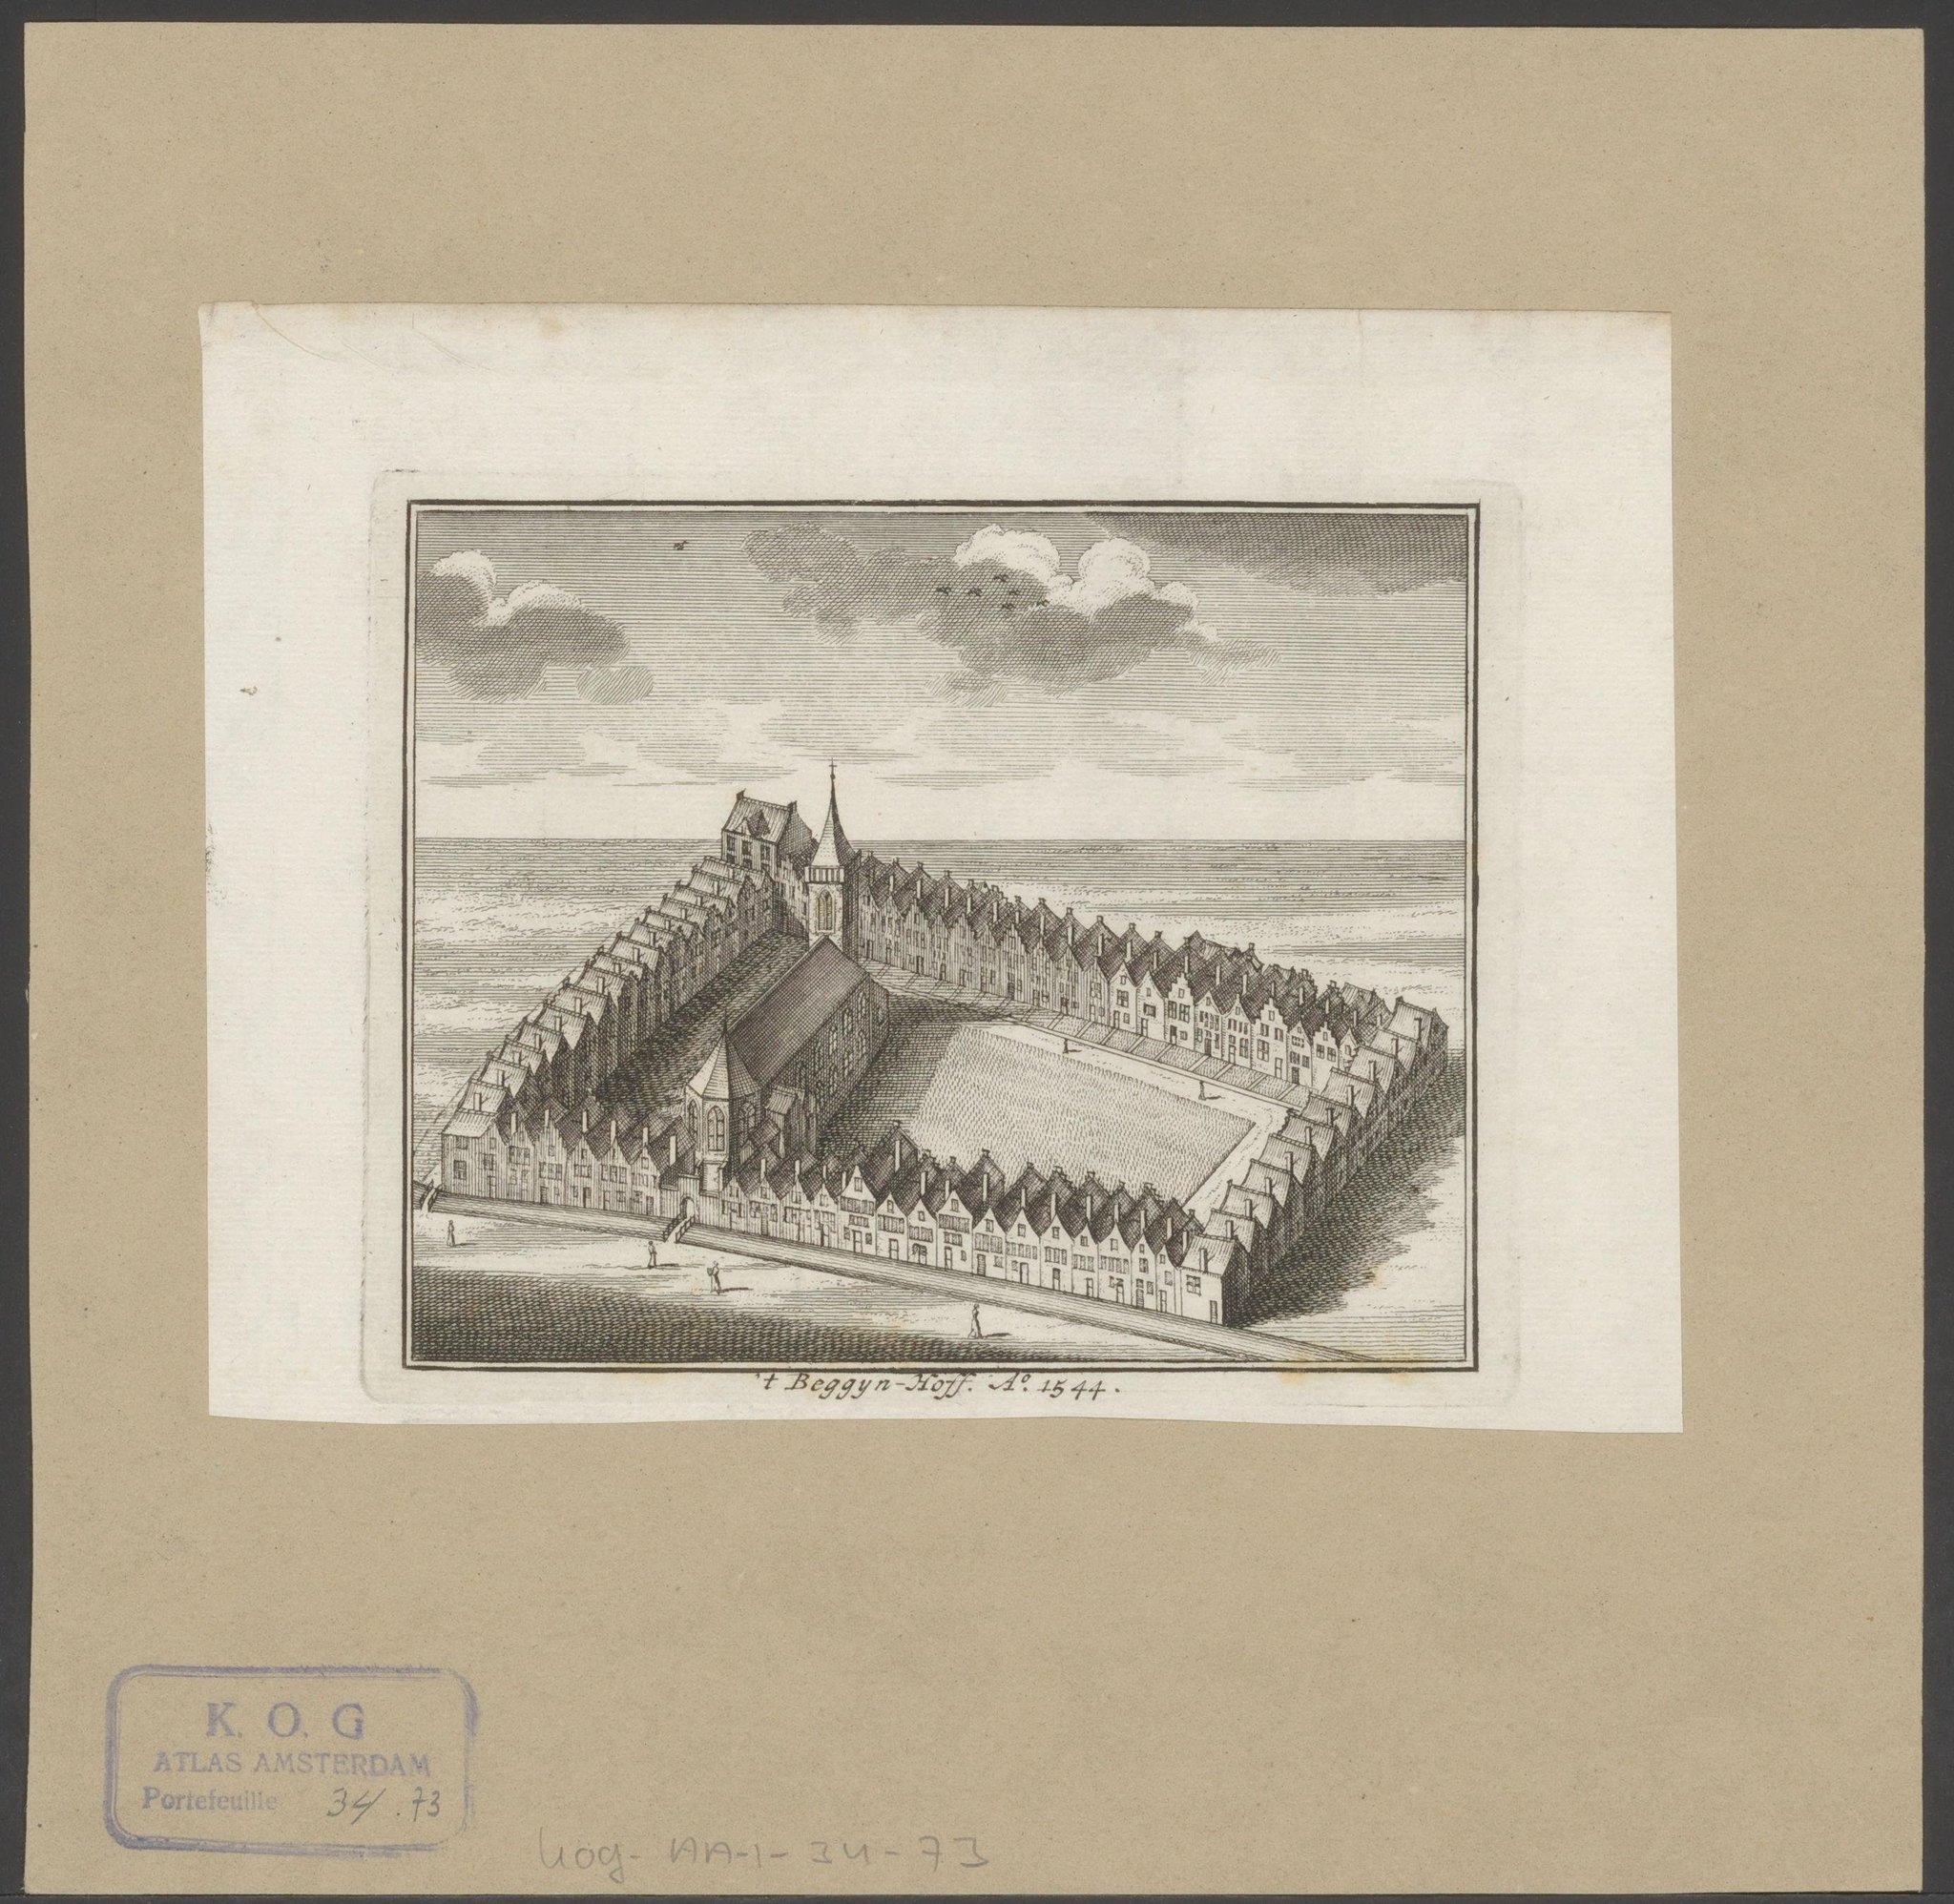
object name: print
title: Gezicht in vogelvlucht op het Begijnhof te Amsterdam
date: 1729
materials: paper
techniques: engraving, etching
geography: northern netherlands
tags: abbey, monastery, convent ~ roman catholic church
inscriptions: collector's mark: Lugt 1641b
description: Prent mogelijk uit: Long, Isaac le. Historische beschryvinge van de reformatie der stadt Amsterdam (…). Amsterdam: Johannes van Septeren (I), 1729. Dat de prent de situatie rond 1544 weergeeft, gaat terug op het feit dat voor het maken van deze en andere prenten van kloosters en kerken van voor de Alteratie (1578) is uitgegaan van de plattegrond van Cornelis Anthonisz. uit 1544, zie RP-P-OB-70.399 en RP-P-AO-20-15.